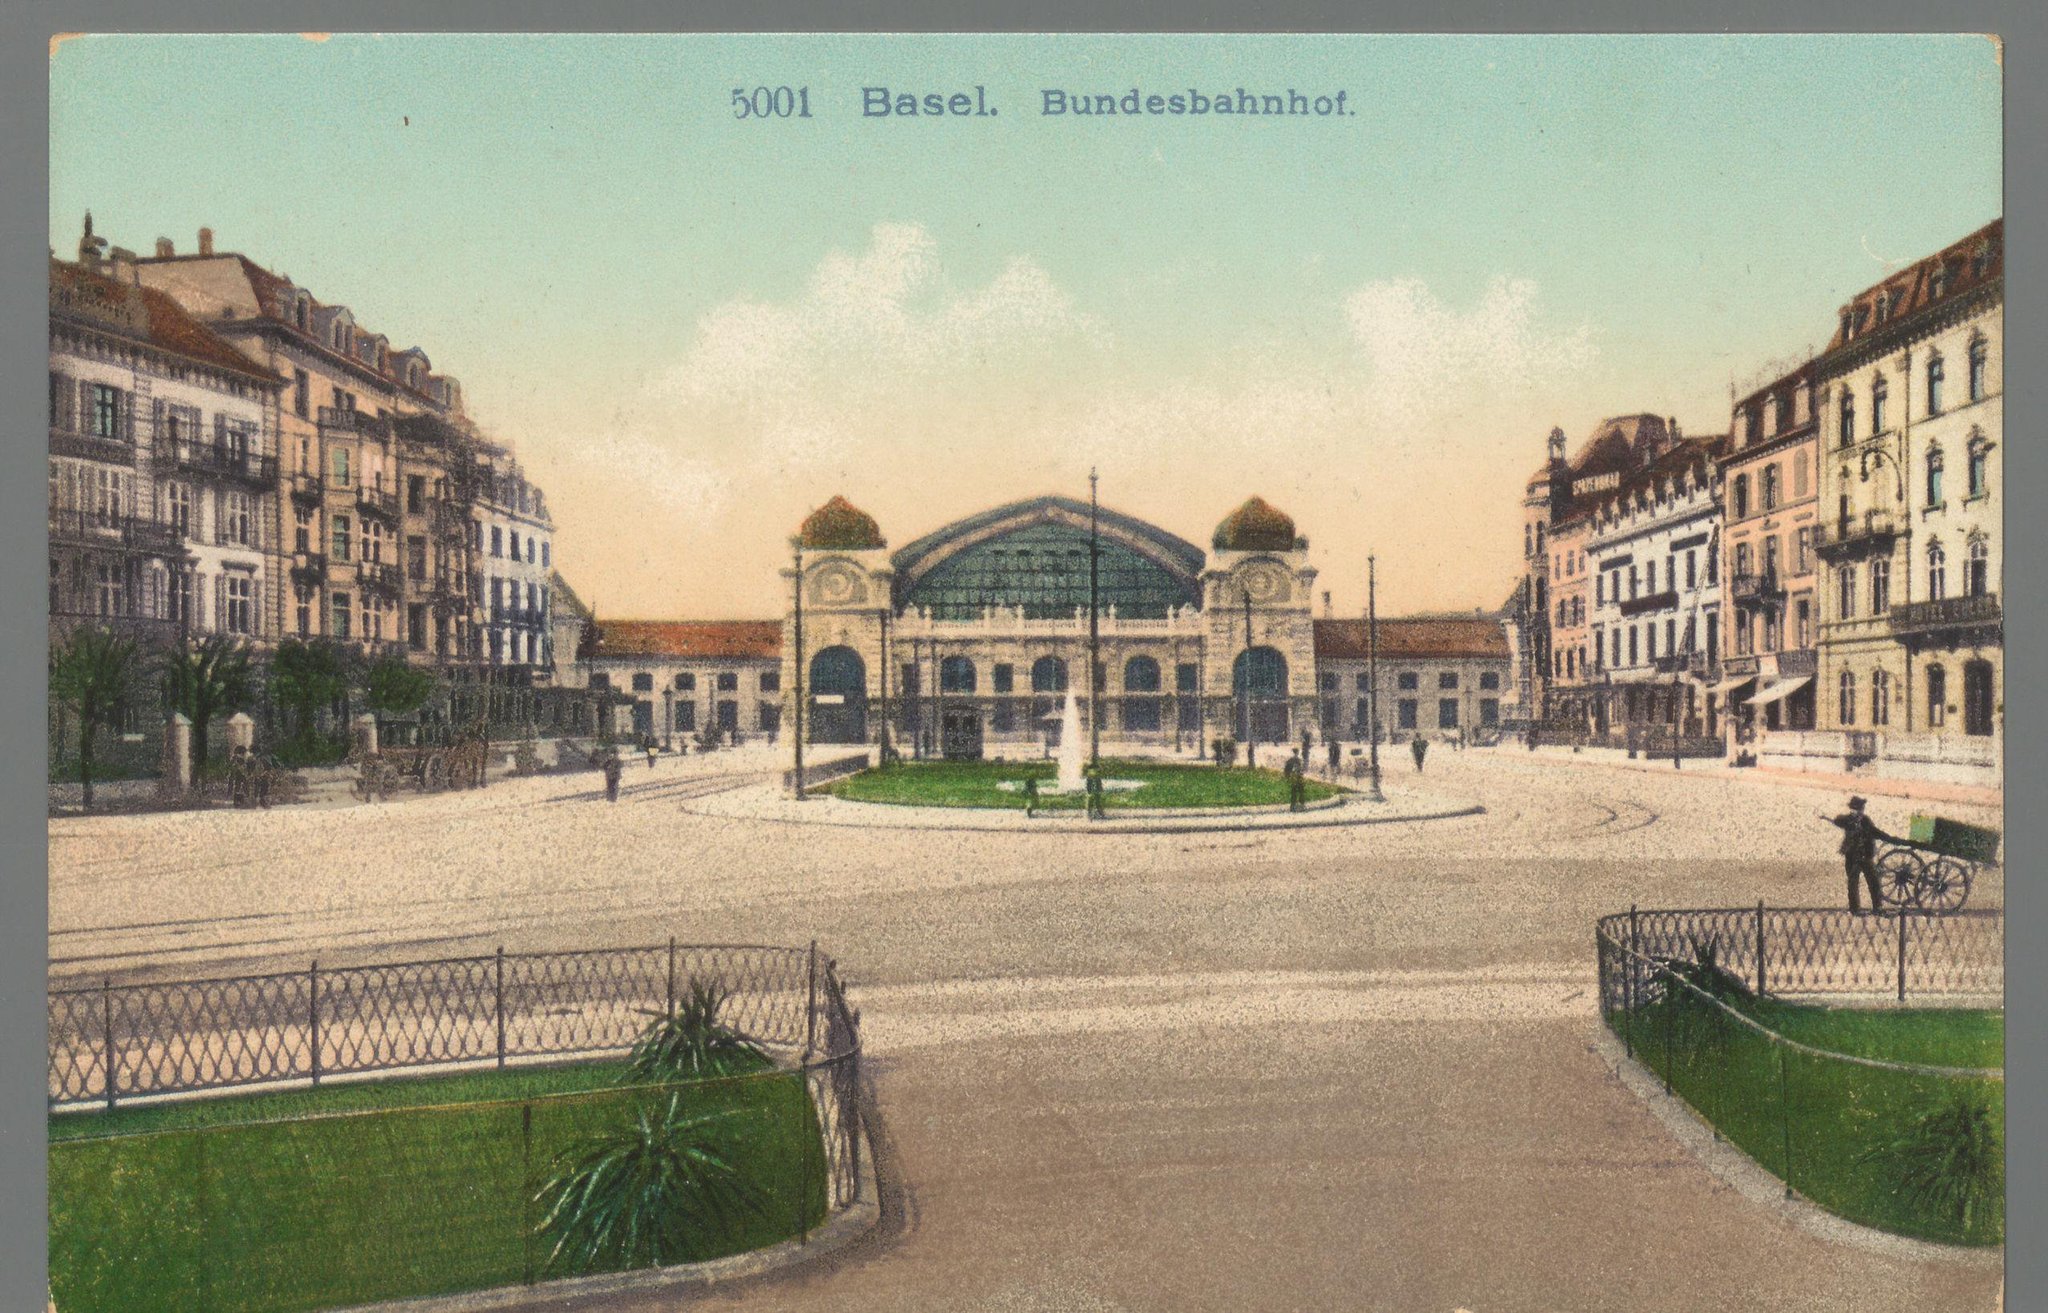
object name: photomechanical print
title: Basel. Bundesbahnhof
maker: Anonymous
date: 1905-1908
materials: cardboard, photographic process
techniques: writing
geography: basel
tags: station; shelter (railway, tramway), square, place, circus, etc. (+ city(-scape) with figures, staffage)